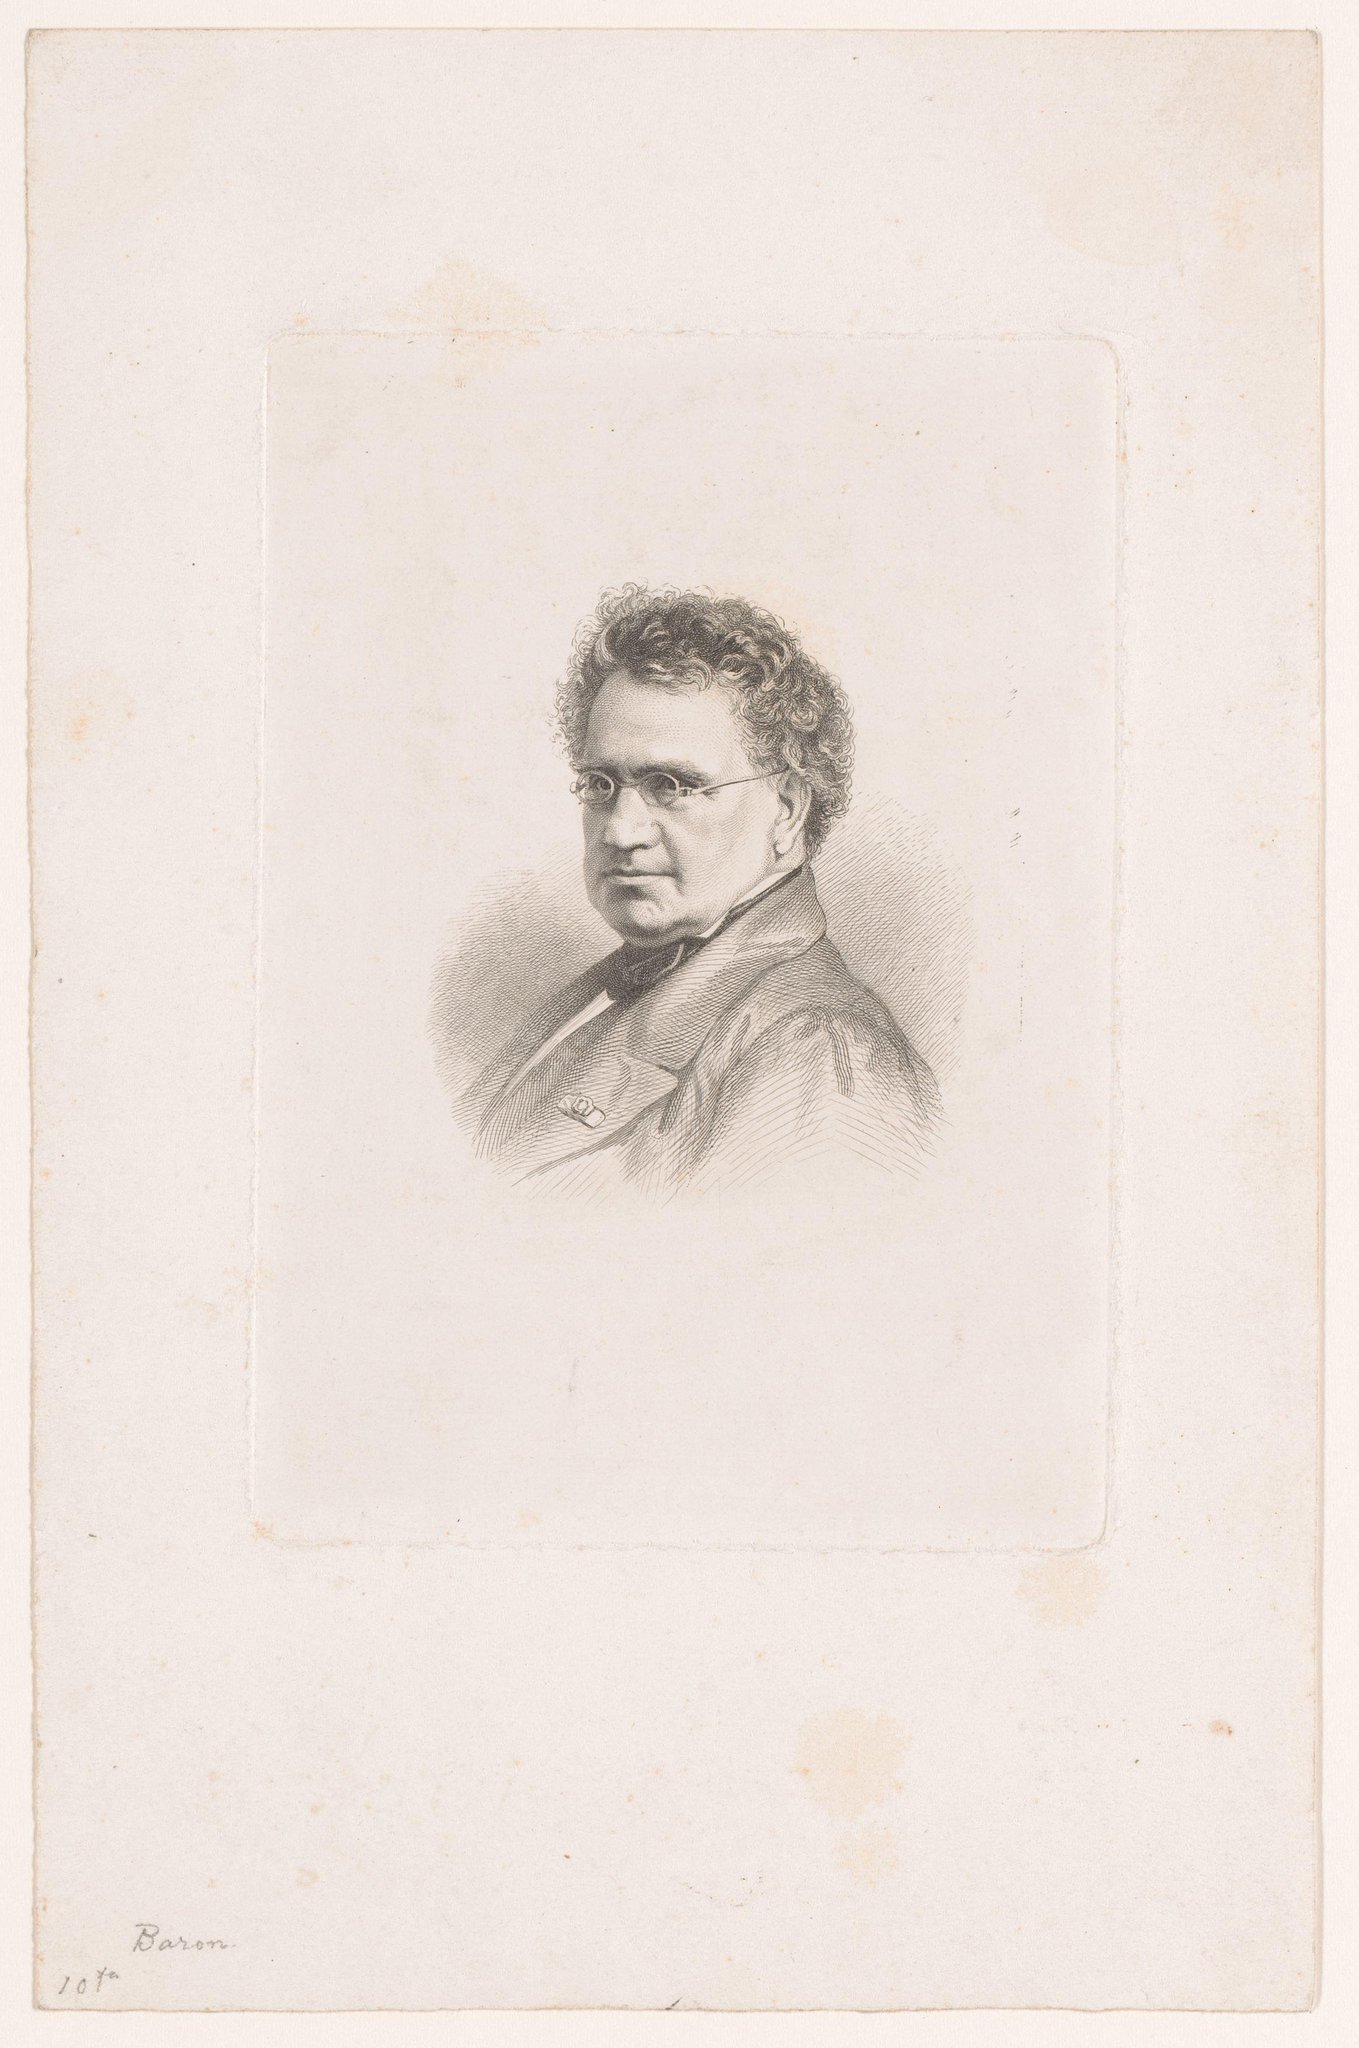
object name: print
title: Portret van A.A.F. Baron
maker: jean-baptiste meunier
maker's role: print maker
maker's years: 1821-1900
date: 1831-1888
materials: paper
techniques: etching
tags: eyeglasses, spectacles, adult man, historical persons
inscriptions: collector's mark: Lugt 2228